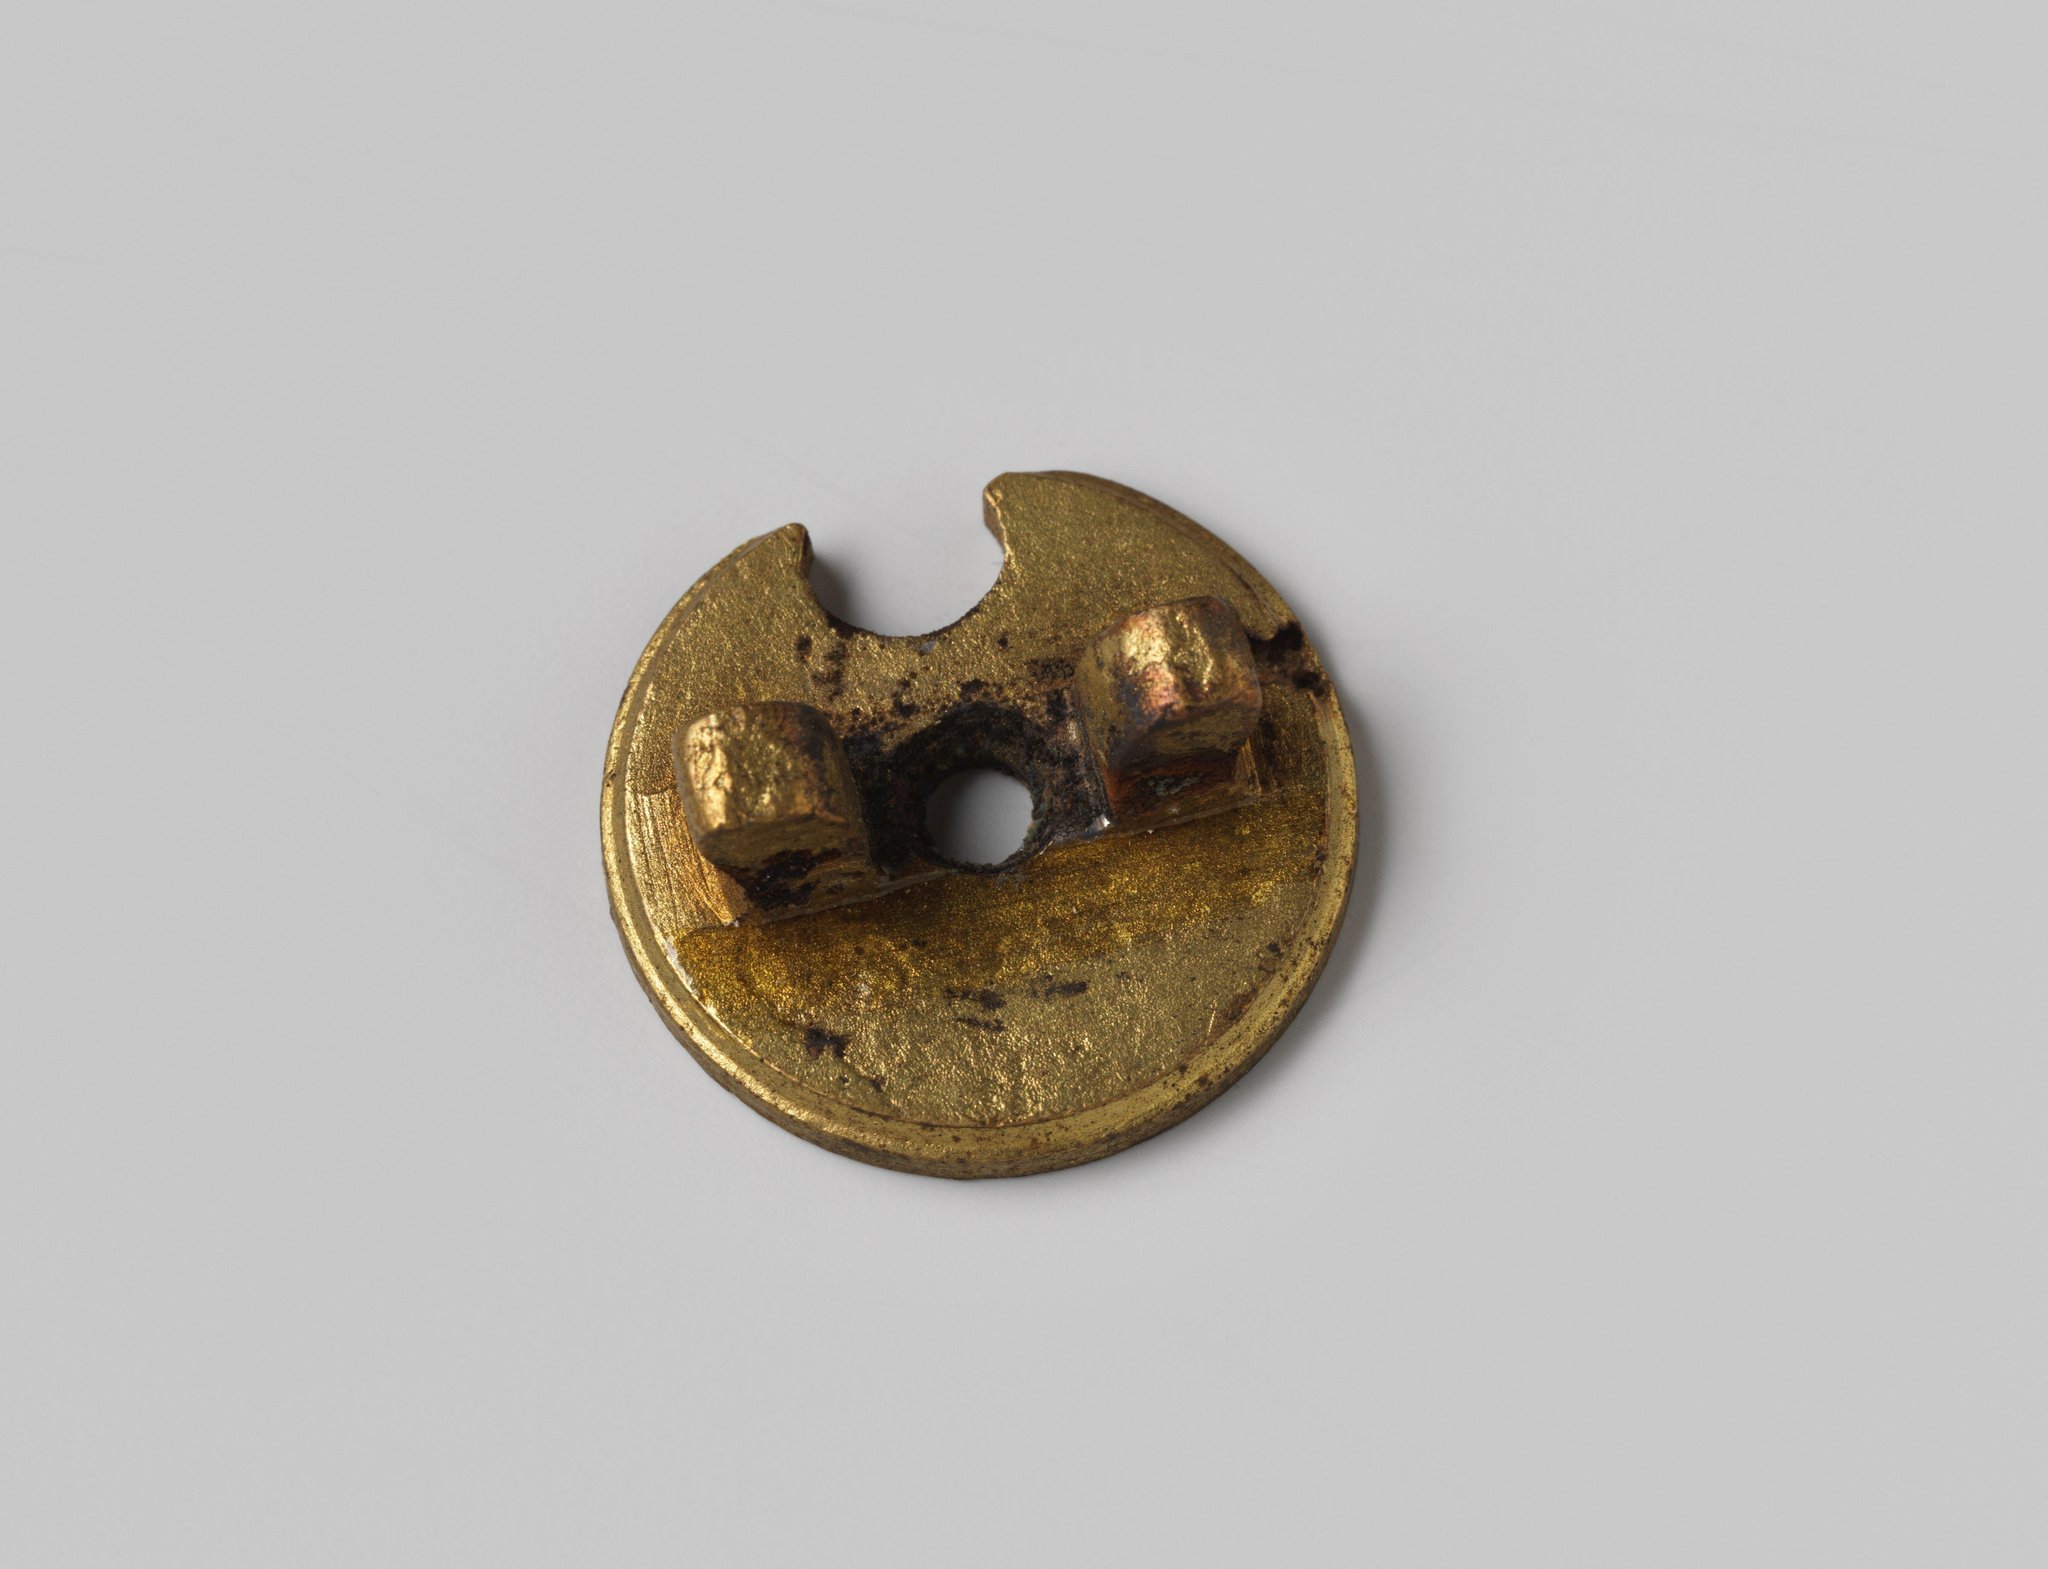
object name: fragment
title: Fragment van koper uit het wrak van de Oost-Indiëvaarder Hollandia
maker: Anonymous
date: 1700-1743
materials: copper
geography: netherlands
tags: verenigde oostindische compagnie, hollandia (schip), annet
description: Varied parts or fragments; unidentified and miscellaneous parts or fragments.